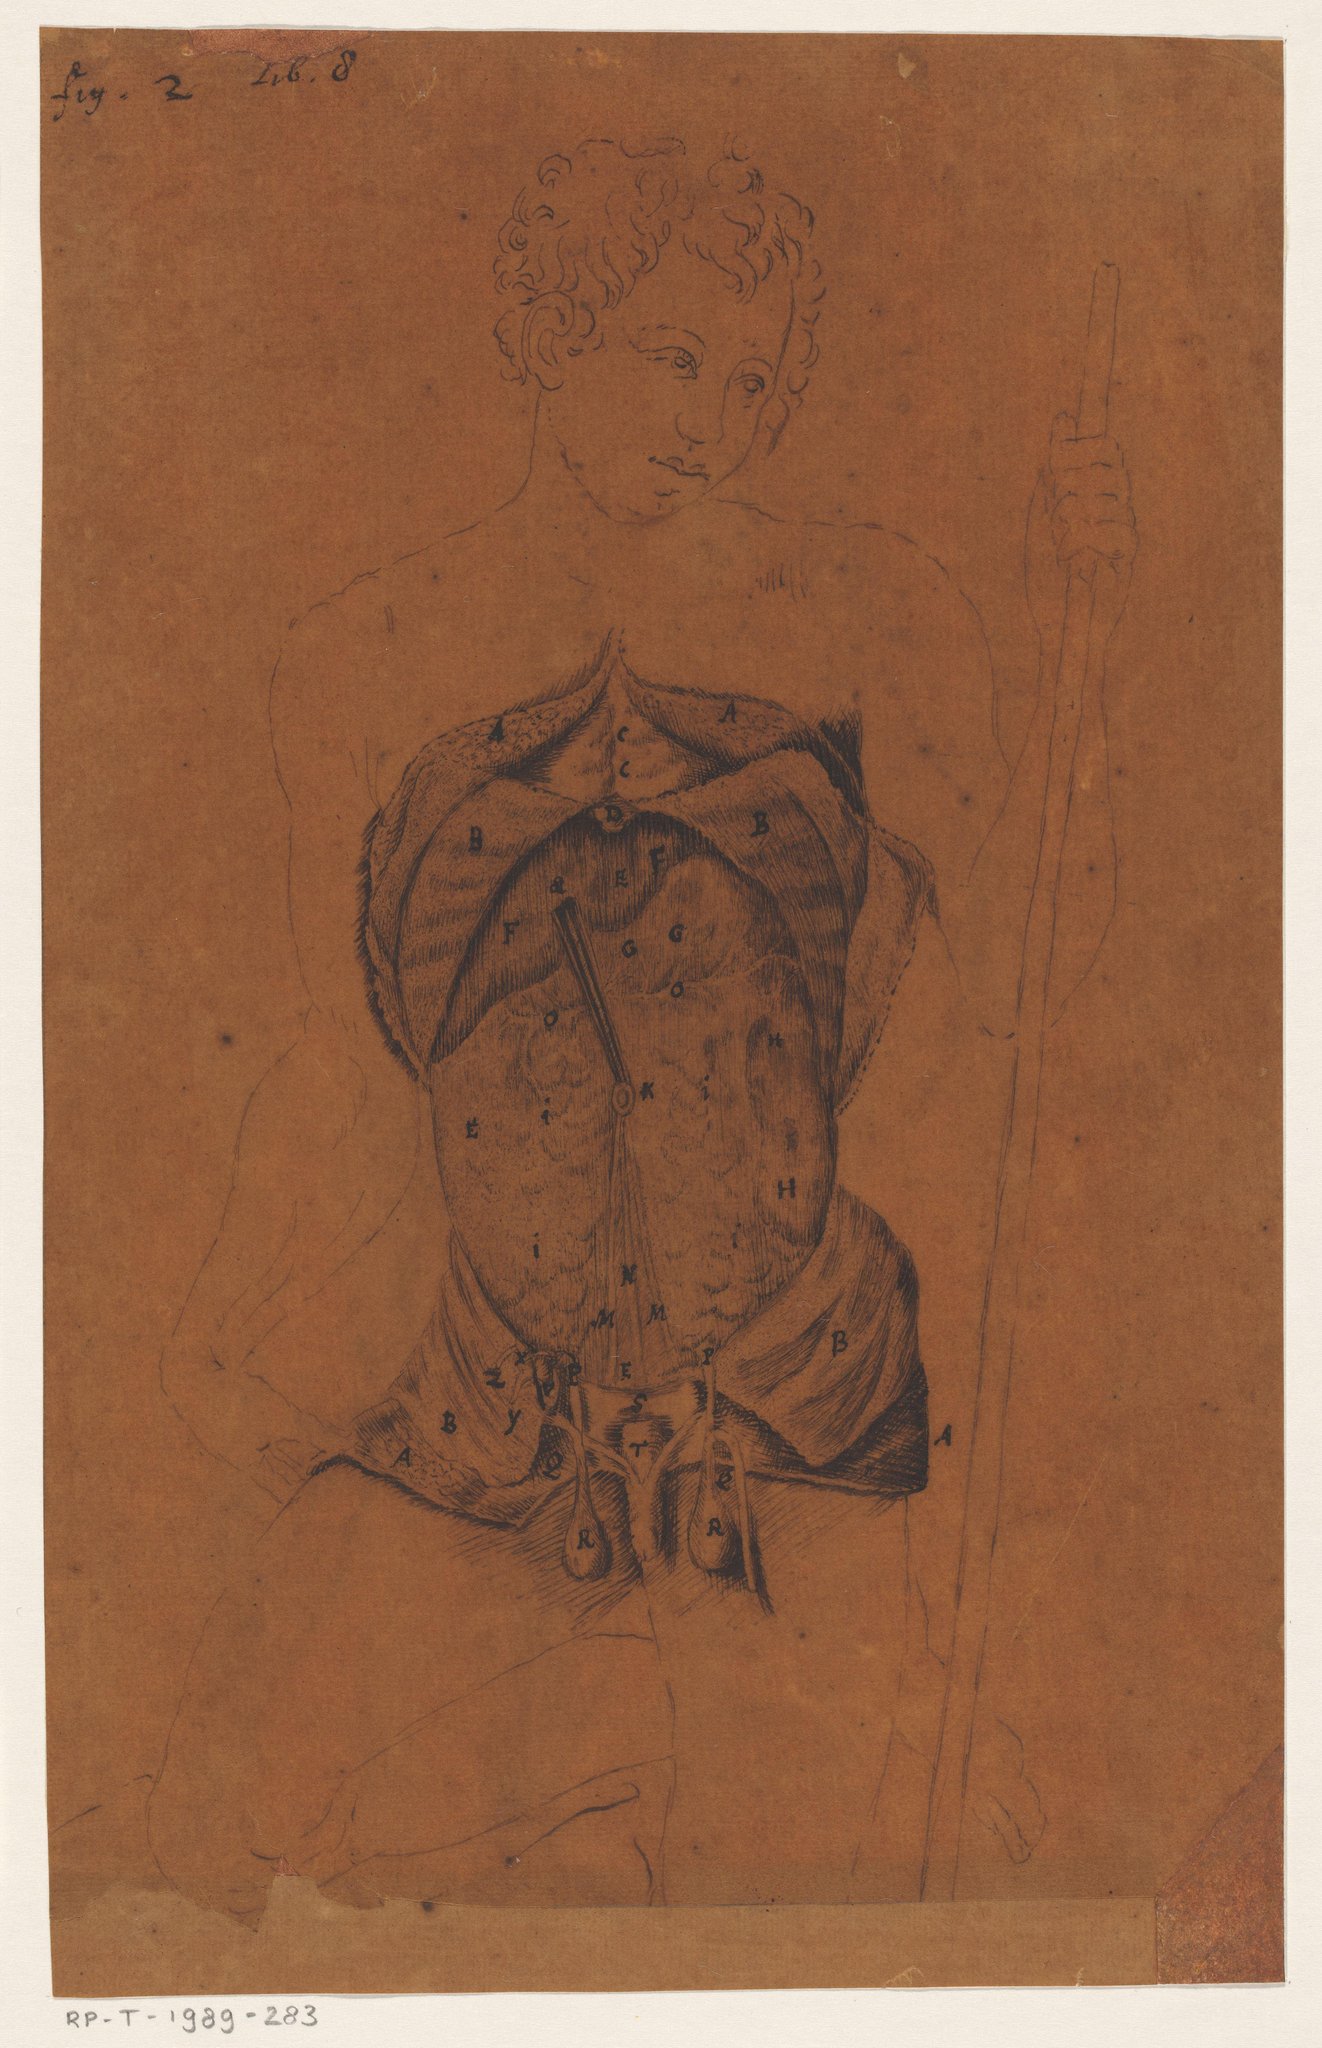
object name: drawing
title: Ingewanden van een man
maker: Anonymous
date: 1630-1649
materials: ink, paper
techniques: pen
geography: low countries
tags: intestines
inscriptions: collector's mark: Lugt 2228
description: De tekening en de letters die de verschillende onderdelen aanduiden komen overeen met een prent uit: Spiegel, Adriaan van den, en Daniel Bucretius. De humani corporis fabrica libri decem. Venetië: s.n., 1627. Tekening zit in een omslag met meerdere anatomische tekeningen, genummerd RP-T-1989-256 en RP-T-1989-258 t/m RP-T-1989-289.